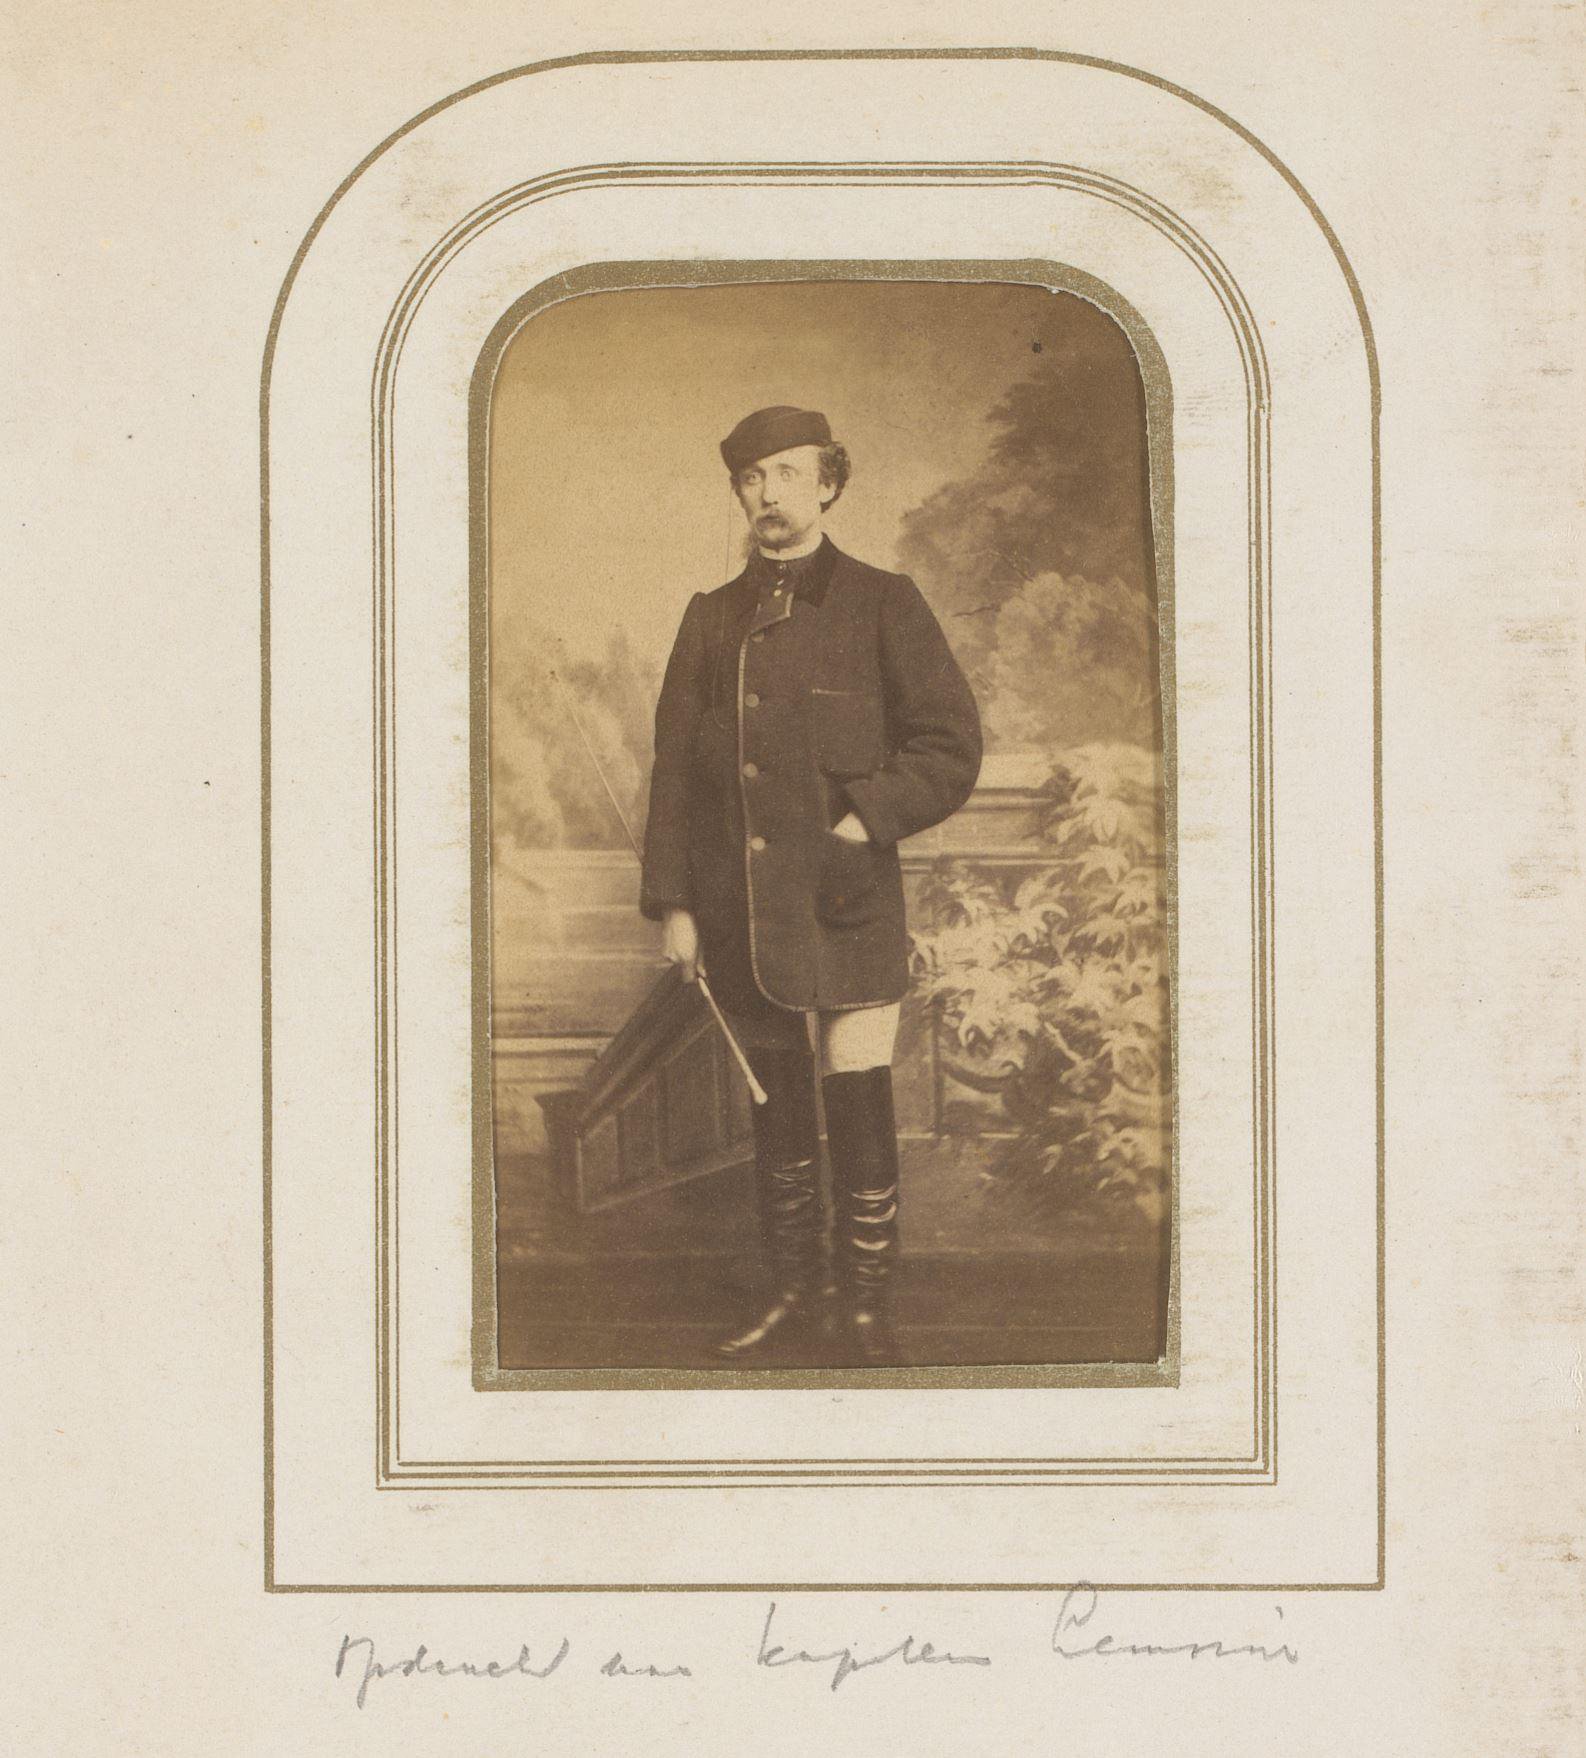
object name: album leaf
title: Portret van een staande man met hoed en wandelstok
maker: Anonymous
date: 1860-1890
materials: cardboard, photographic support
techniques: albumen print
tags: walking-stick, staff, historical persons, head-gear: hat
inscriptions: annotation: ‘opdracht aan kapitein Lemoine’